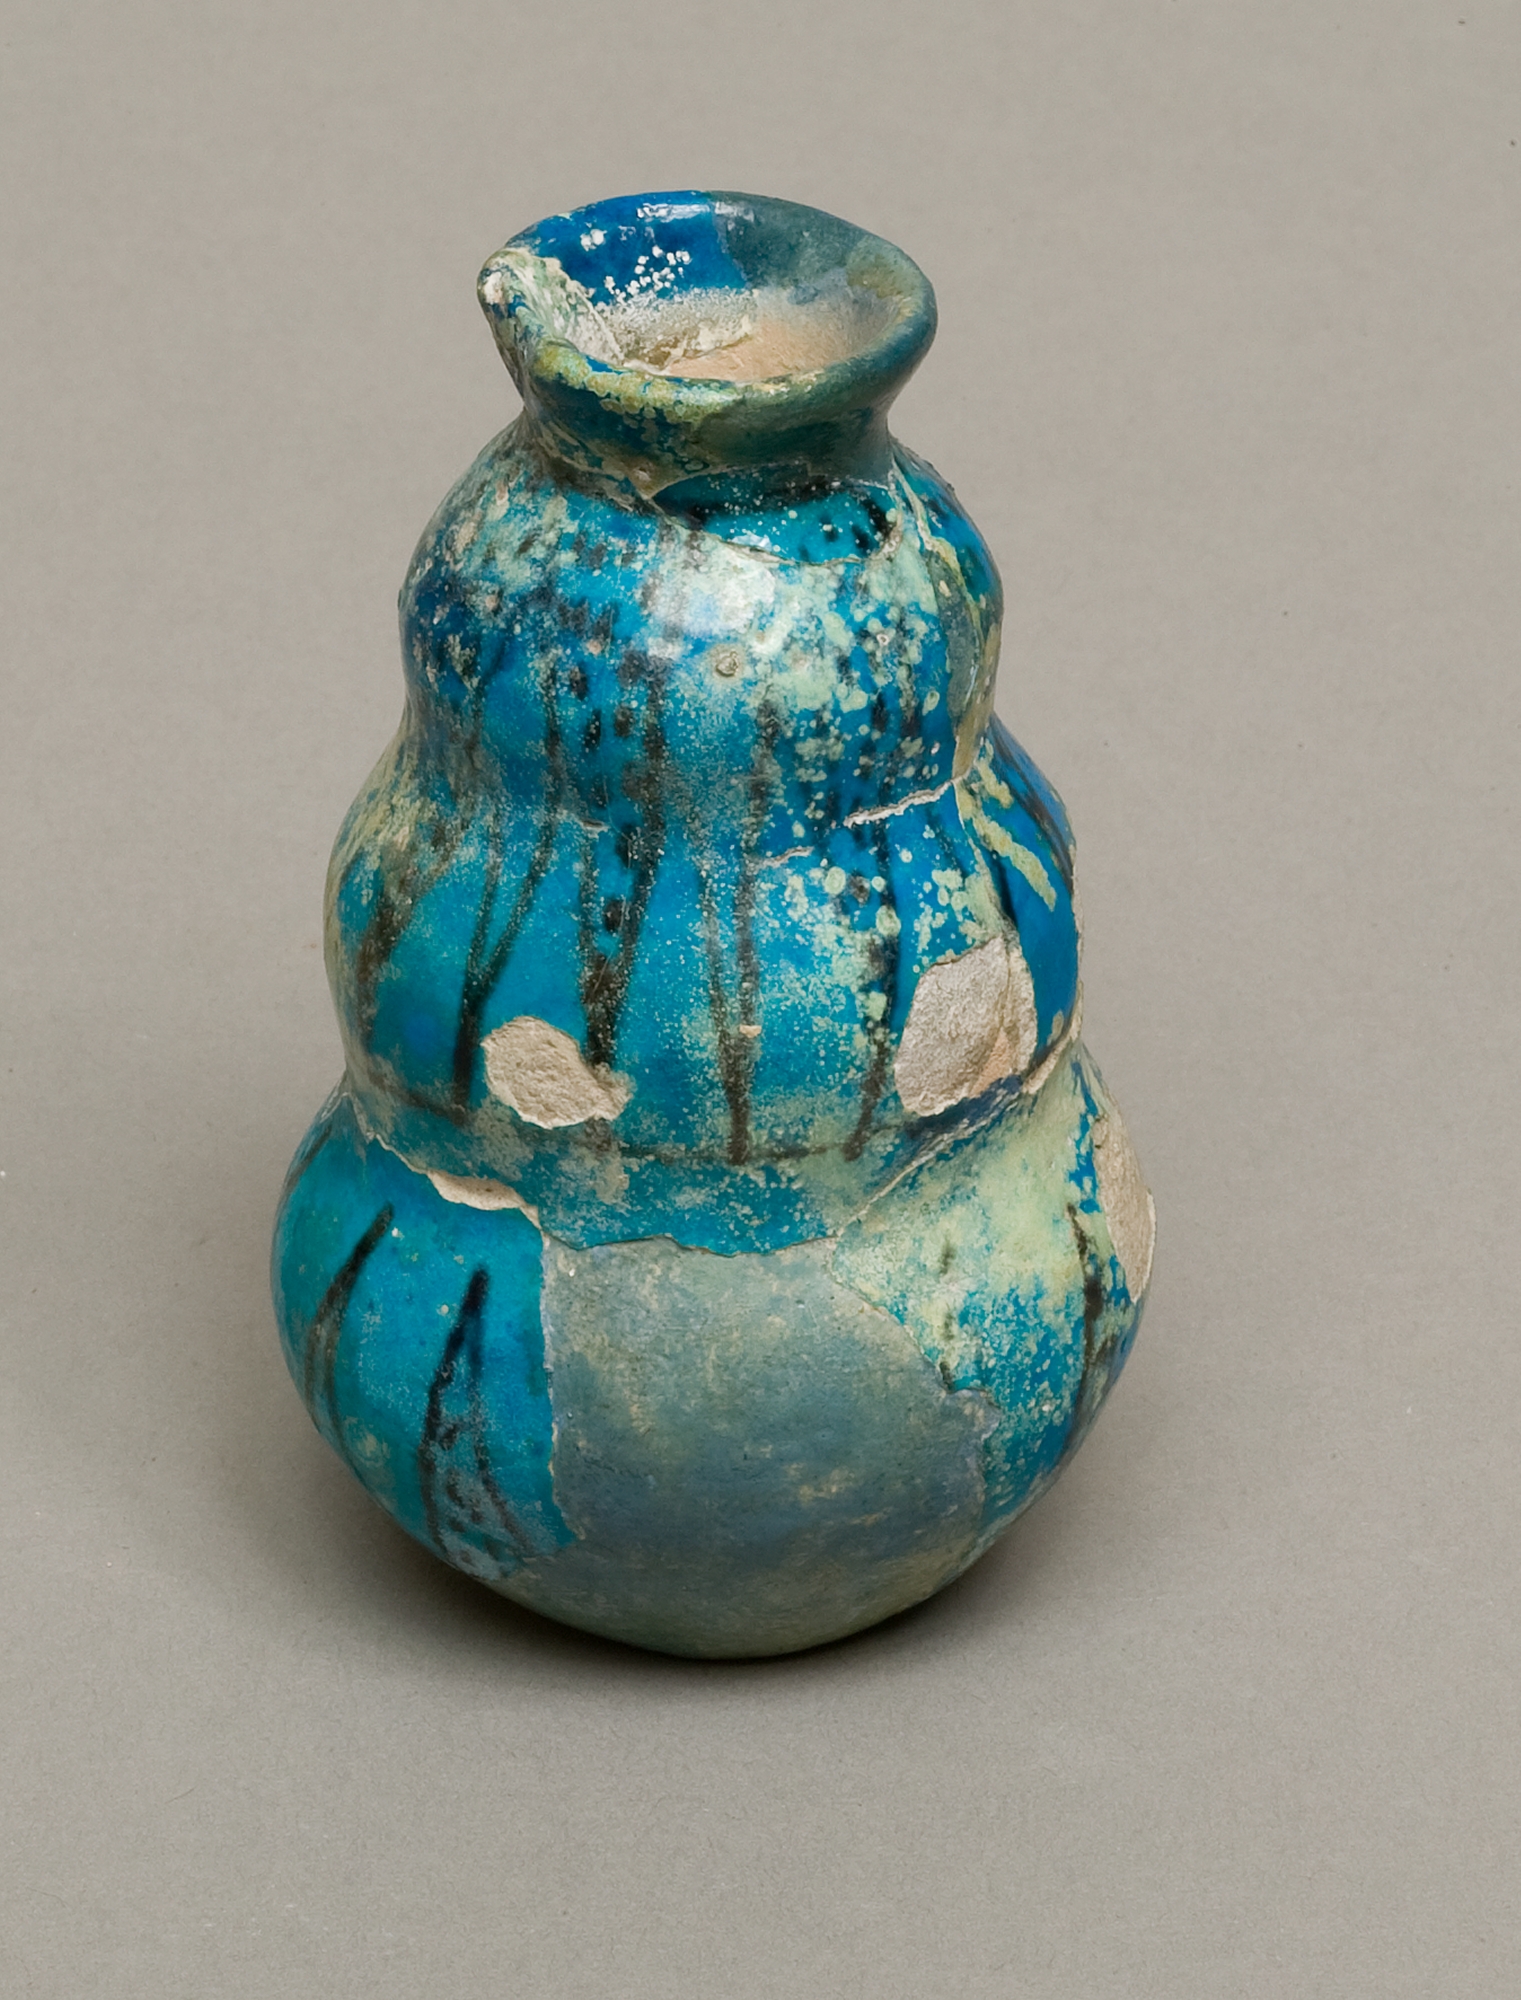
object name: jar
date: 1981-1640 BCE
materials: faience, glaze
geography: egypt